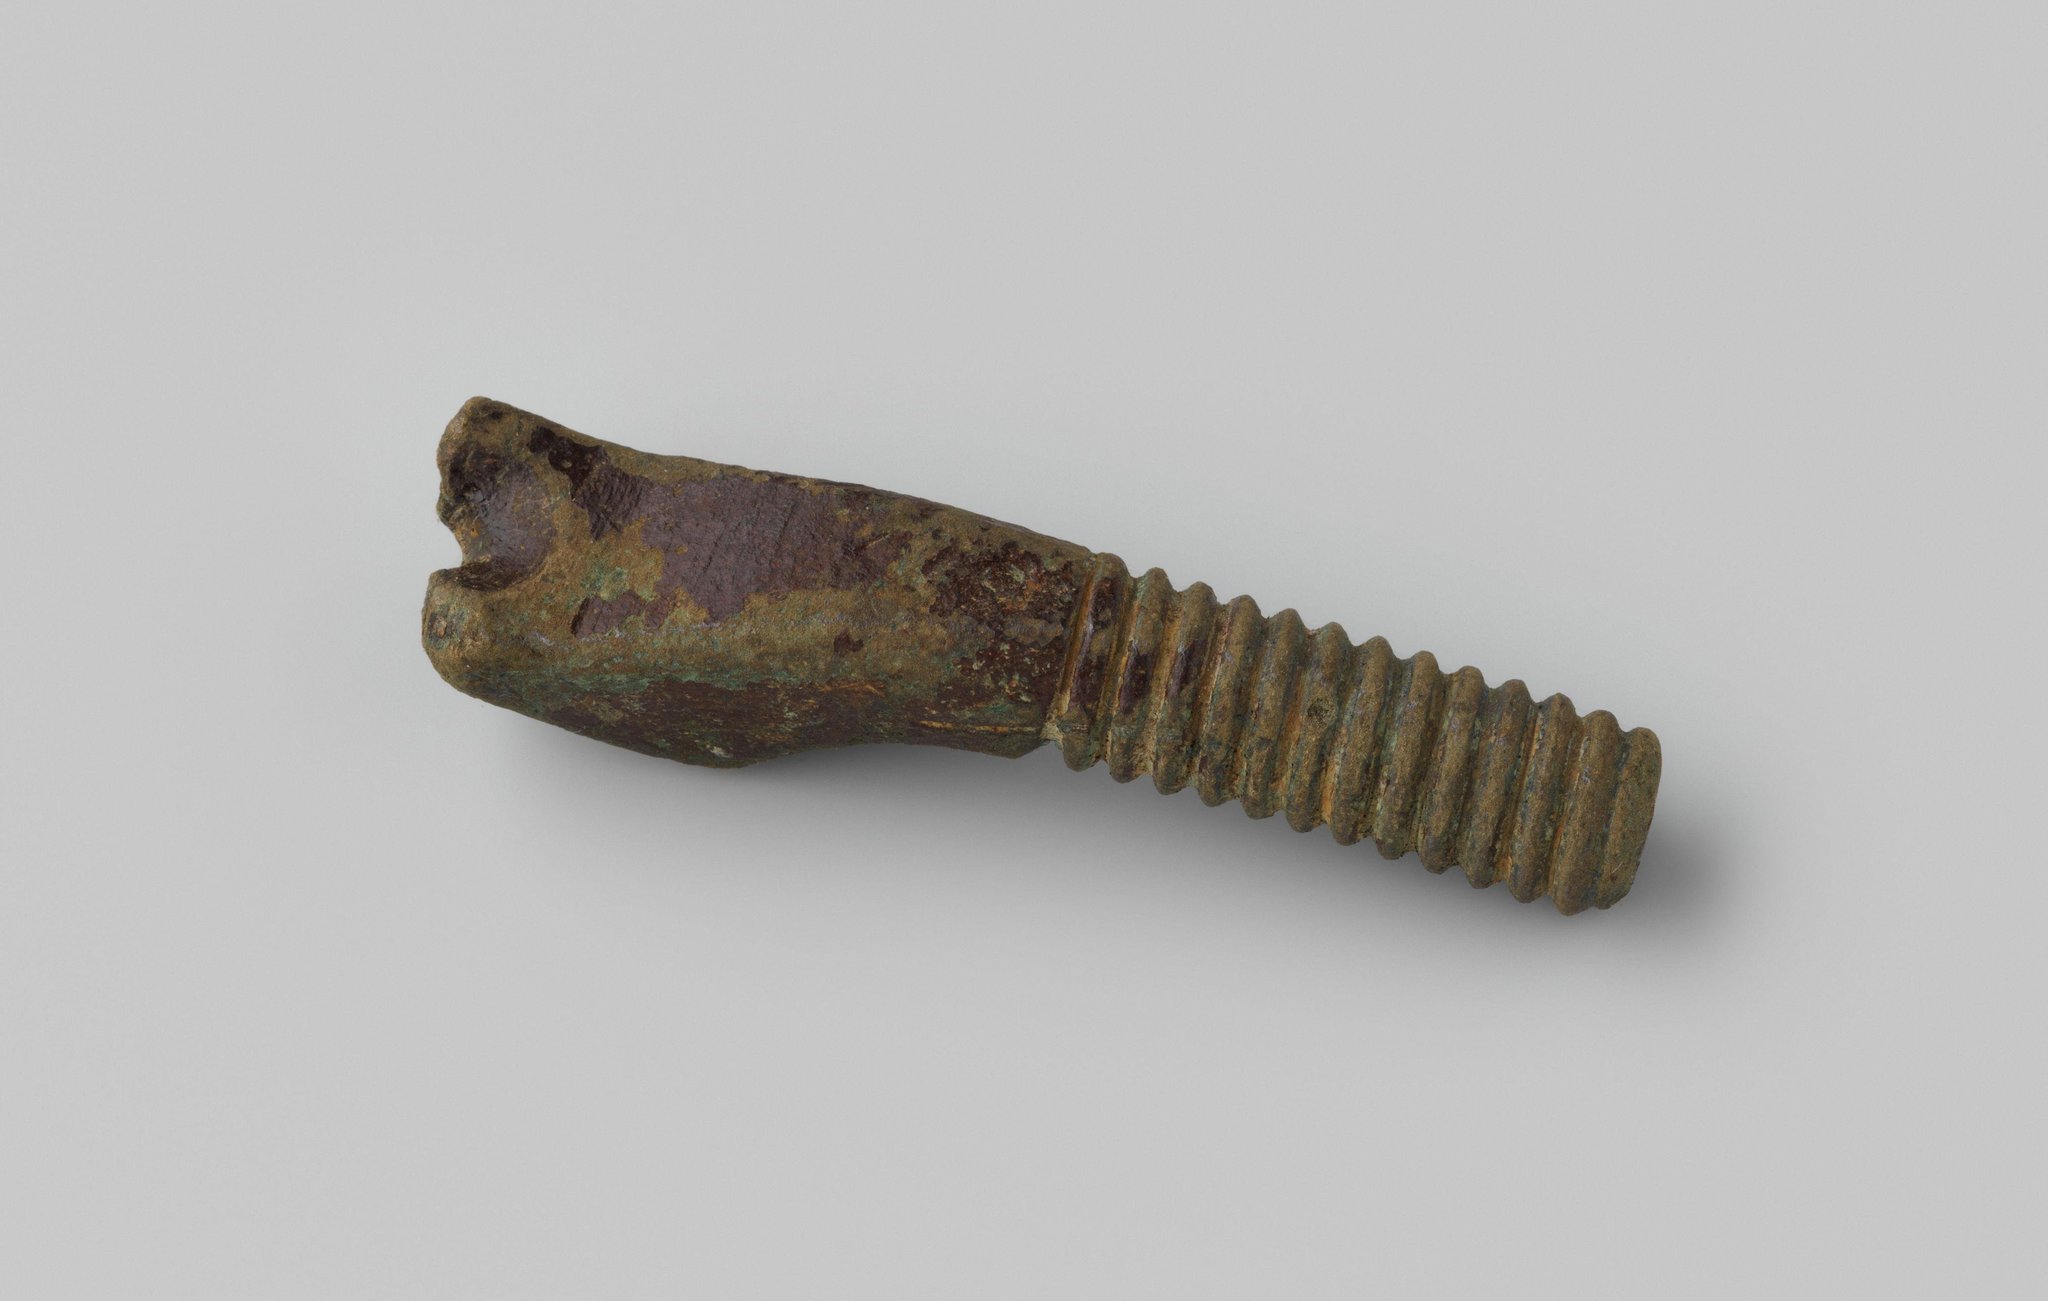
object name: bolt tongs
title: Bout afkomstig uit het wrak van de Oost-Indiëvaarder Hollandia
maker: Anonymous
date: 1700-1743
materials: copper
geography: netherlands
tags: verenigde oostindische compagnie, hollandia (schip)